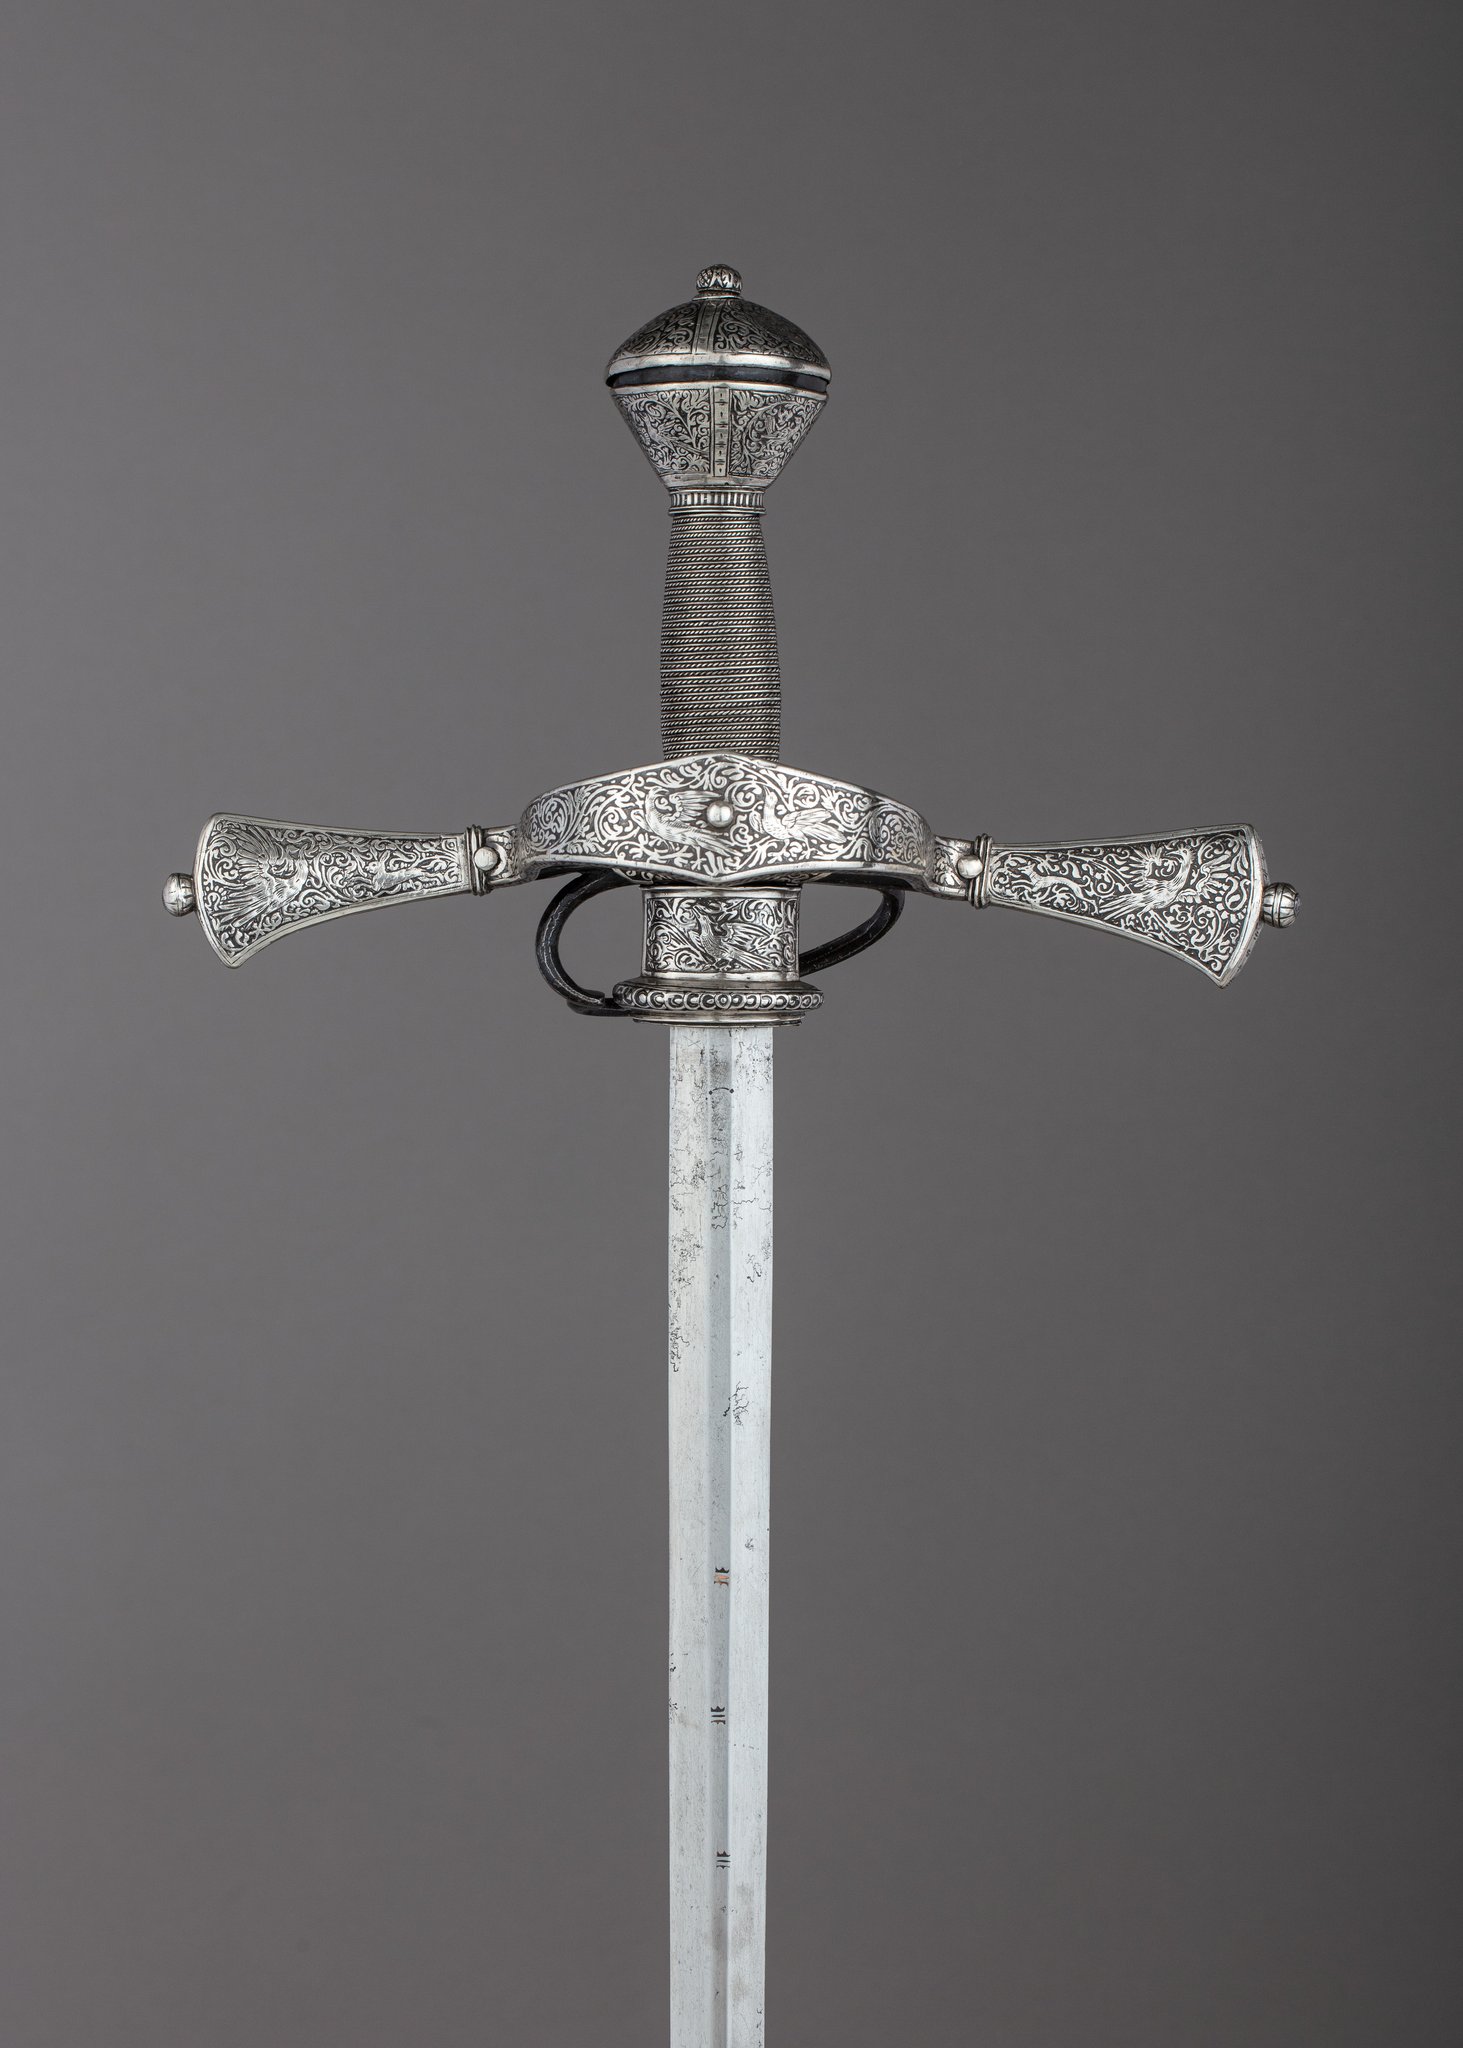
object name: rapier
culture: german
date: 1575-1600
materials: copper alloy, iron, silver, steel, wood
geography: germany